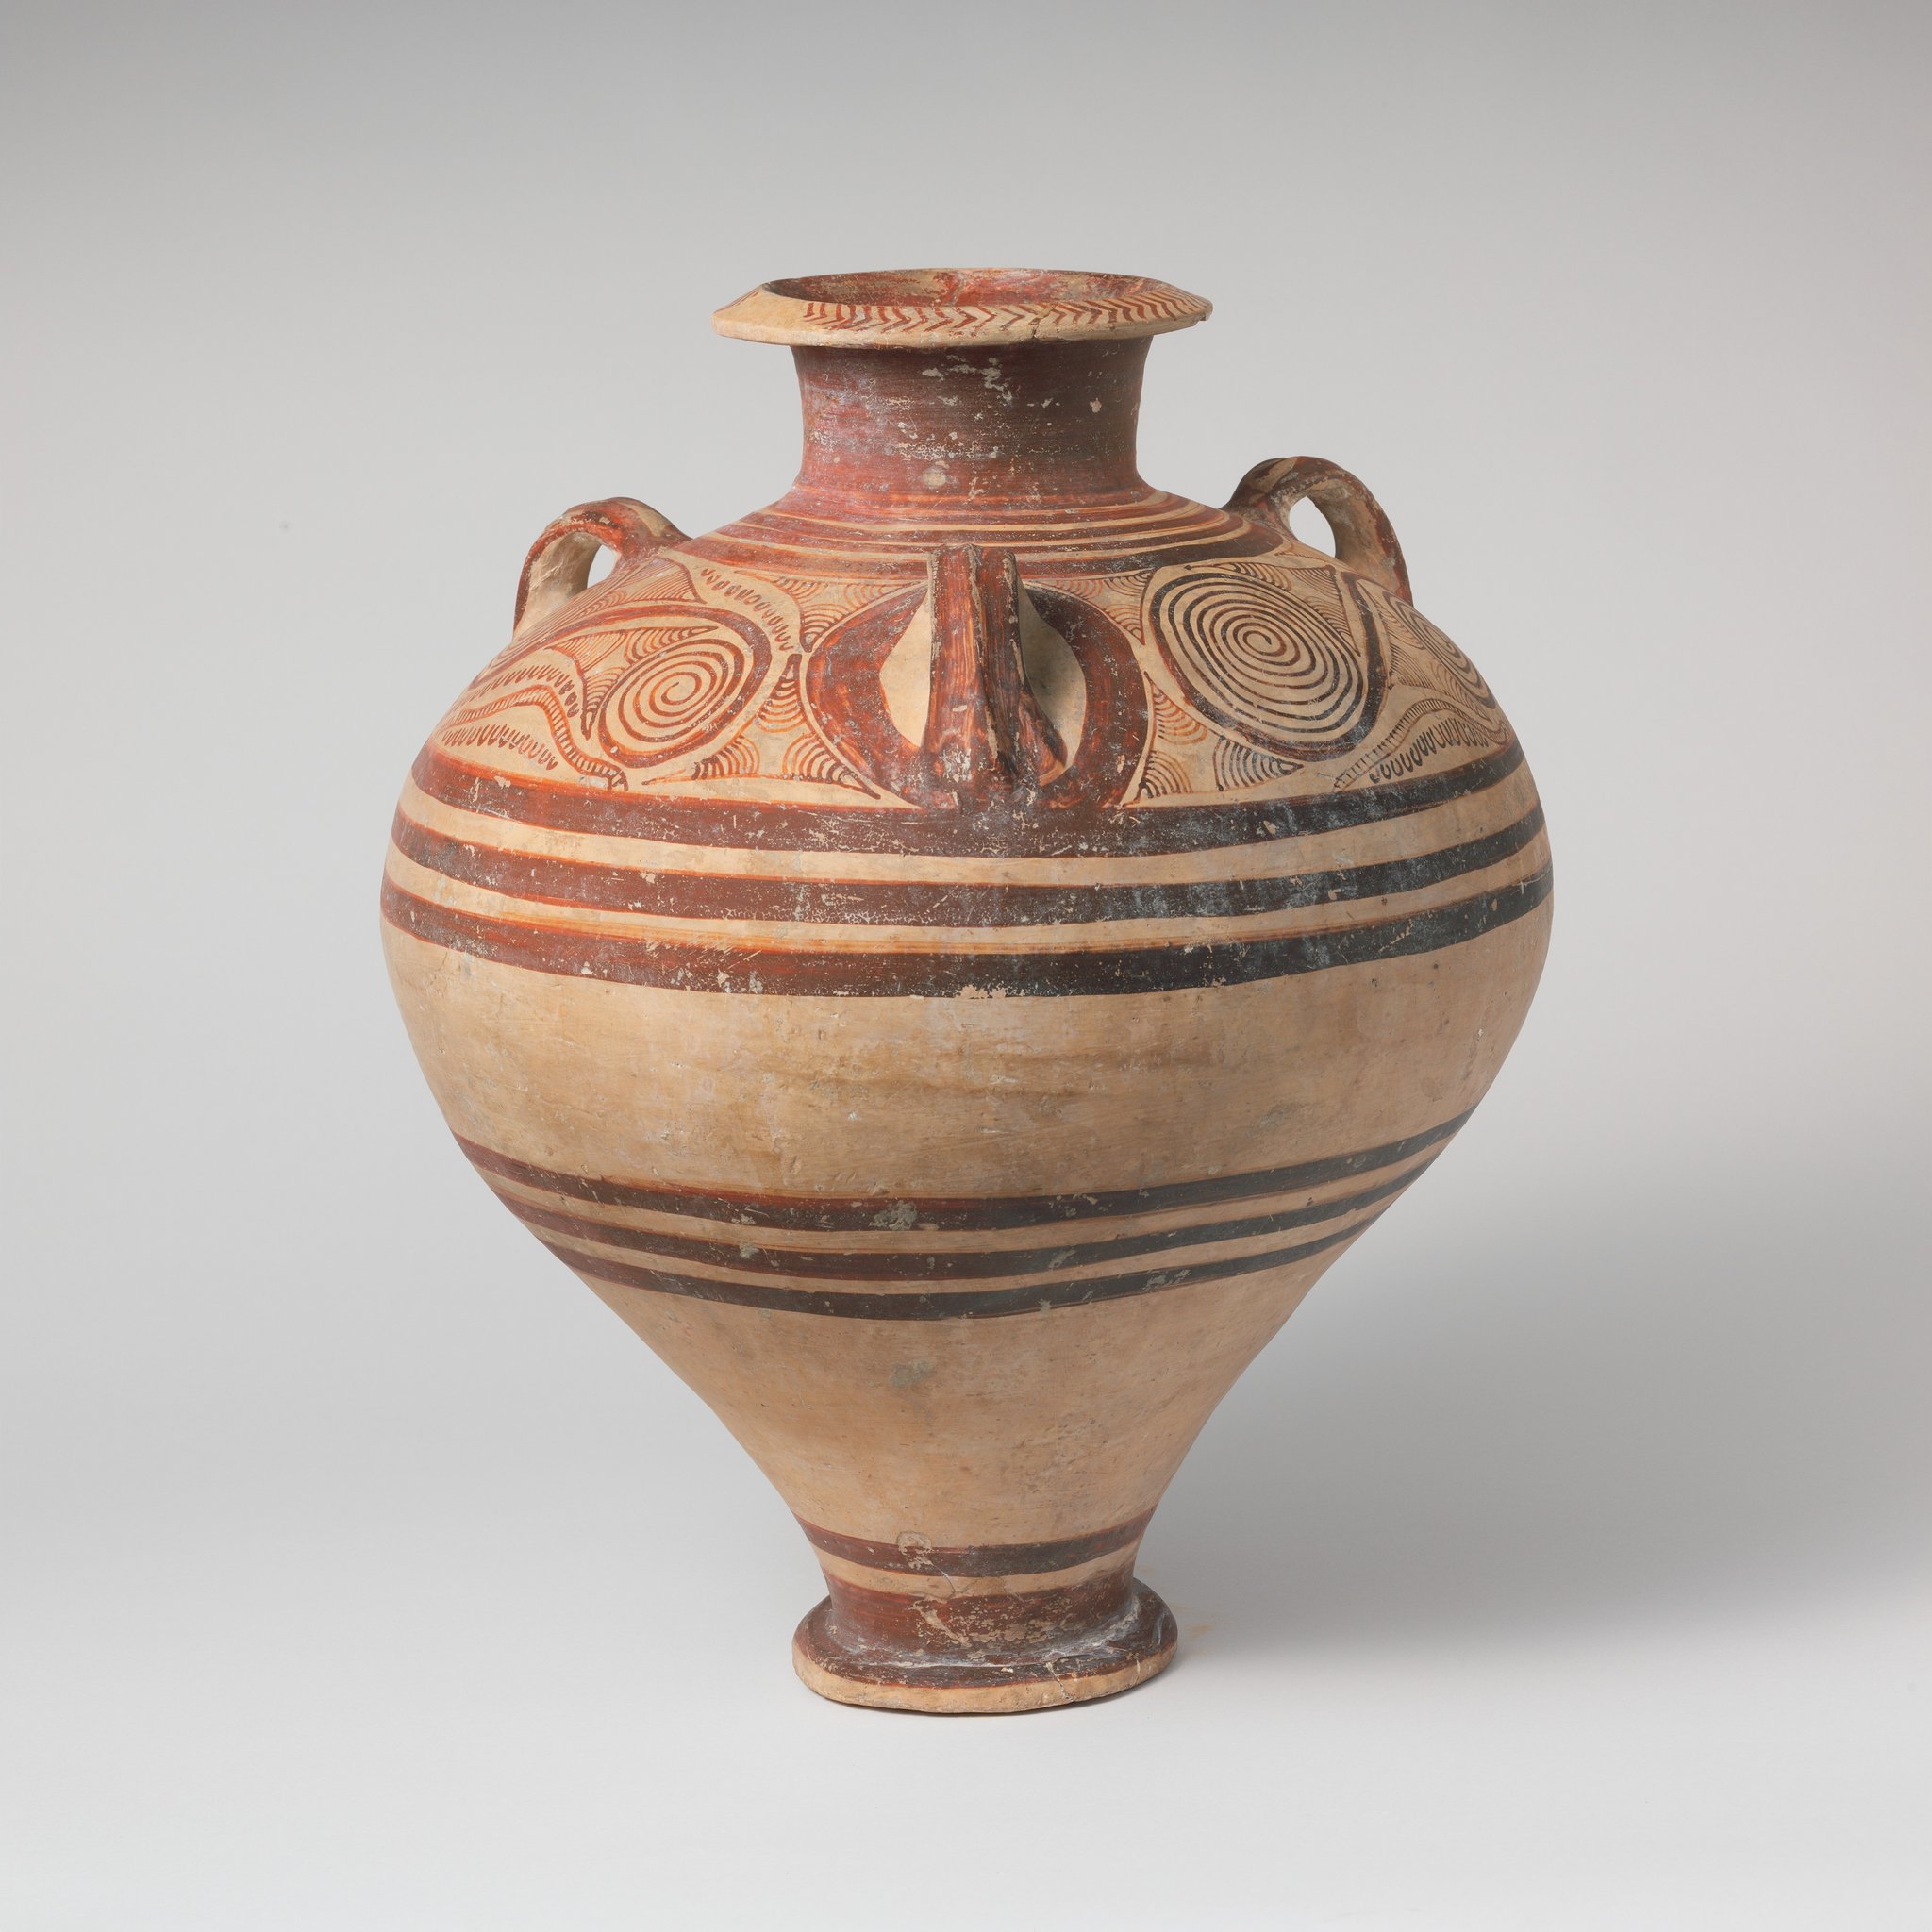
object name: pithoid jar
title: Terracotta pithoid jar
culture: mycenaean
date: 1325-1300 BCE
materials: terracotta